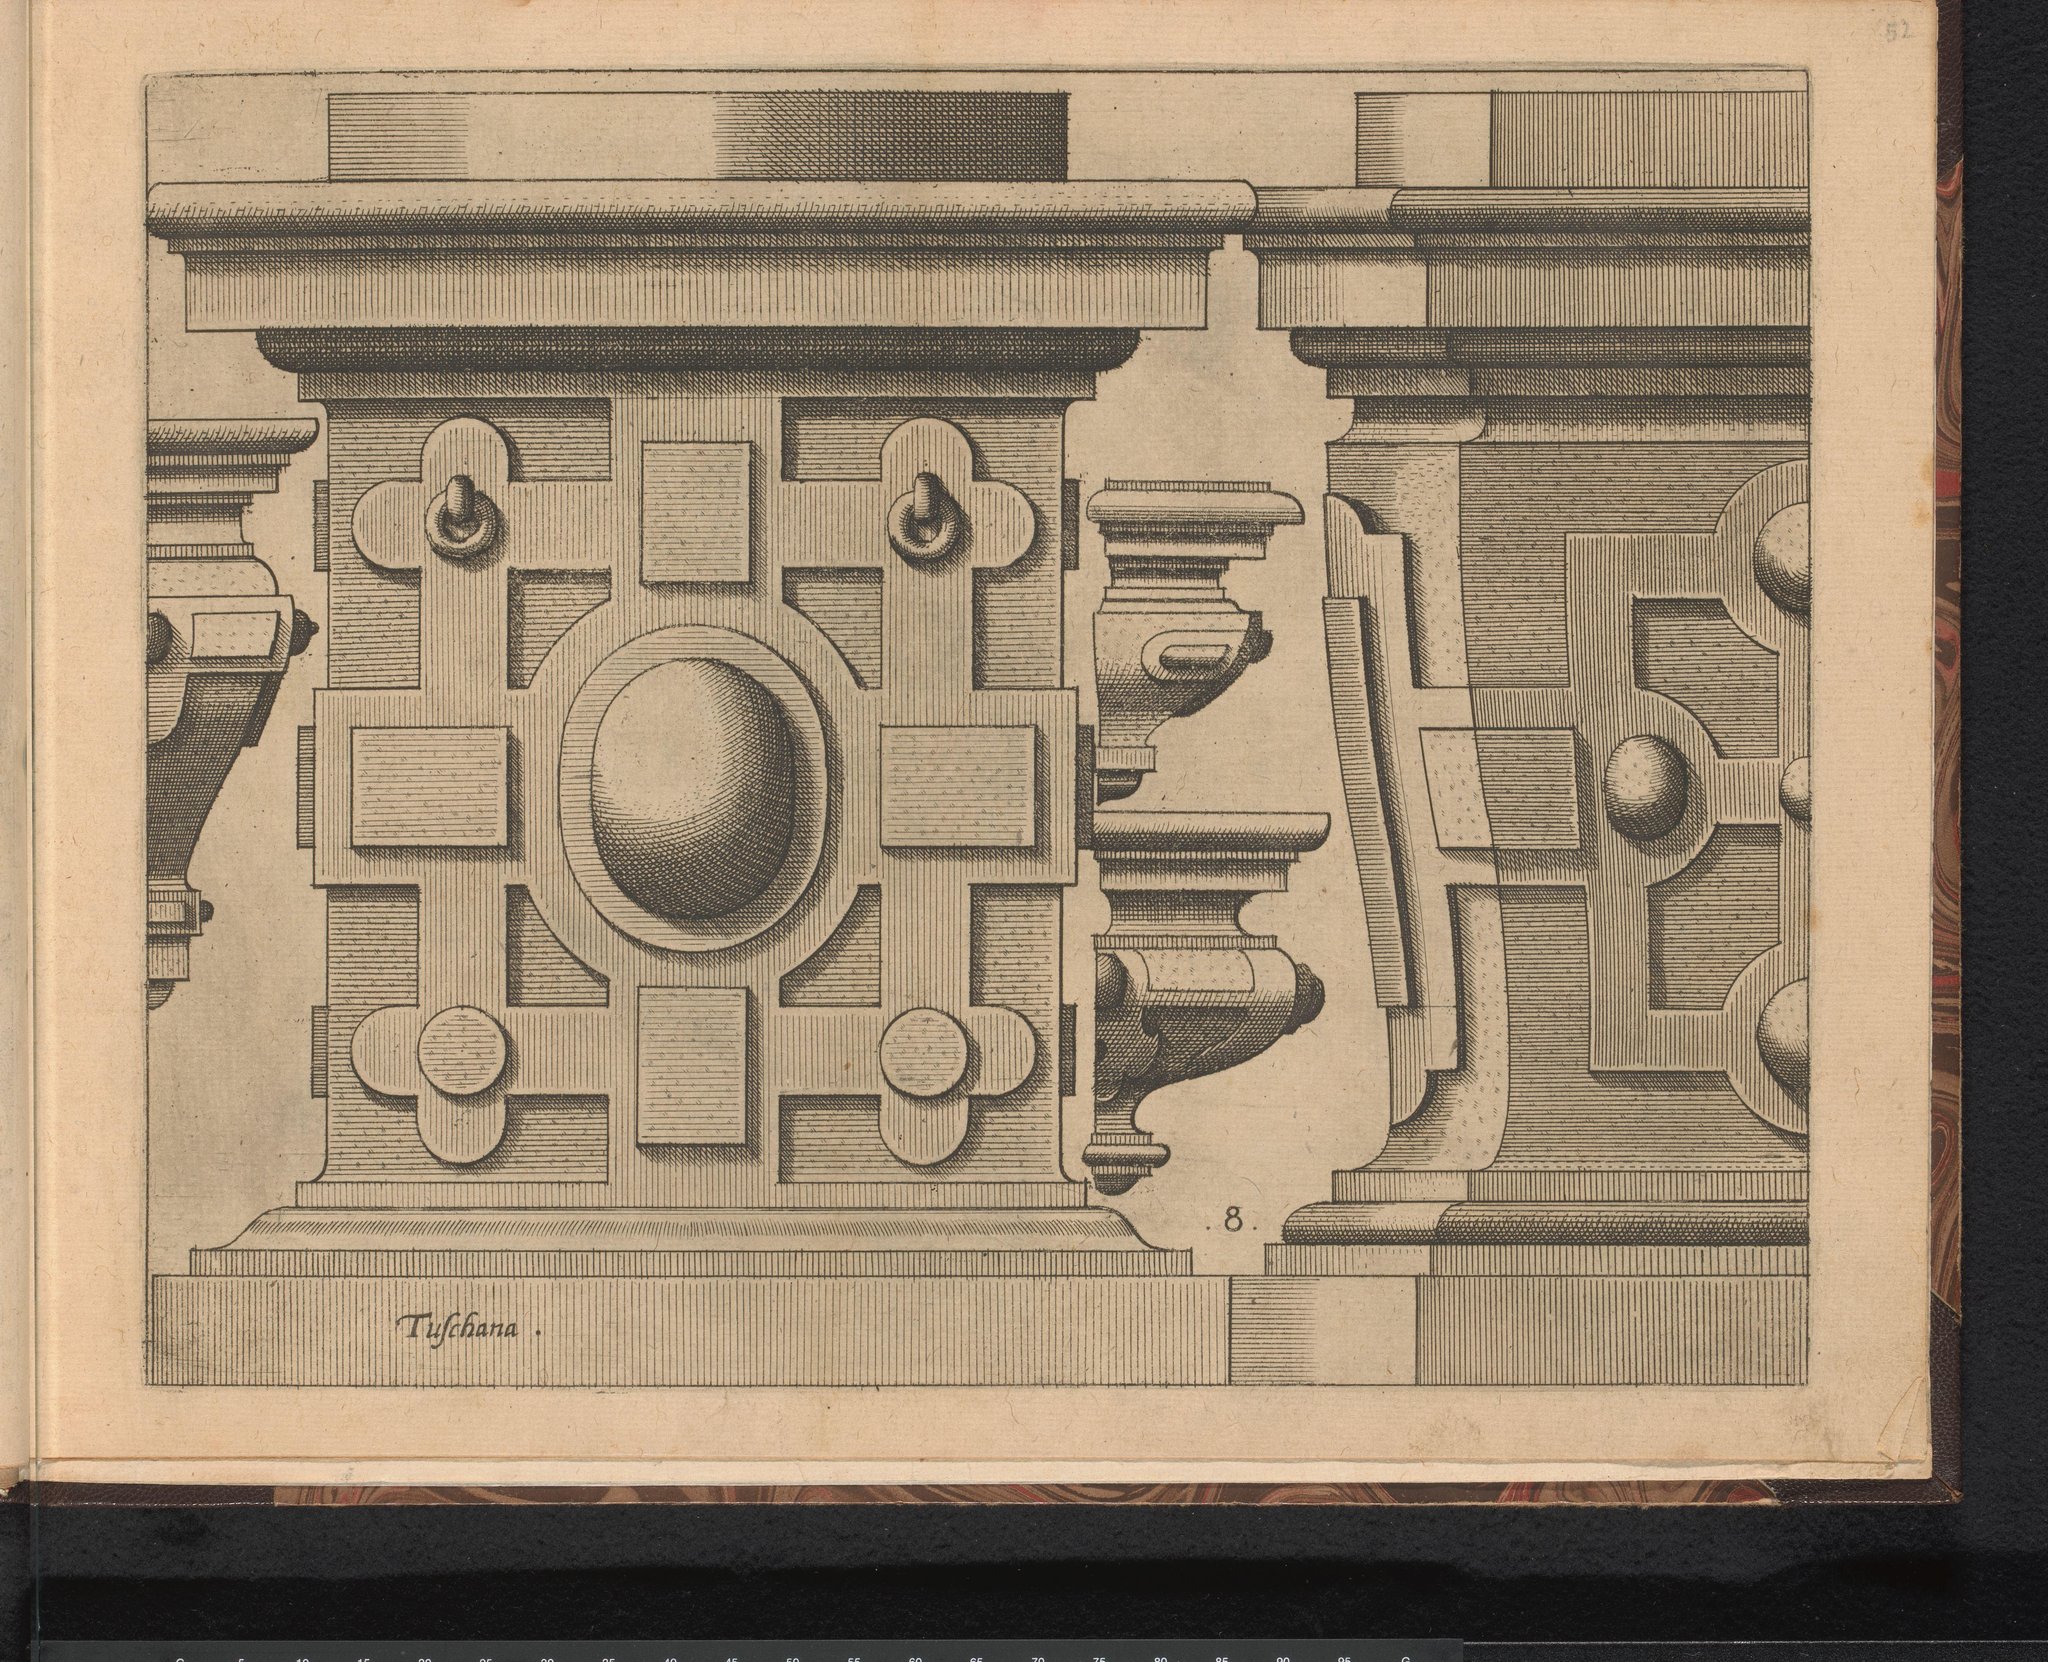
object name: album leaf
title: Hele en halve piëdestal en drie consoles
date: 1578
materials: paper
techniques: etching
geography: antwerp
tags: tuscan order ~ architecture, other architectural details (console), gate, entrance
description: Een hele en halve piëdestal met gestileerde bossage, halve kogels en ringen. Daarbij drie consoles. De prent maakt deel uit van een album.